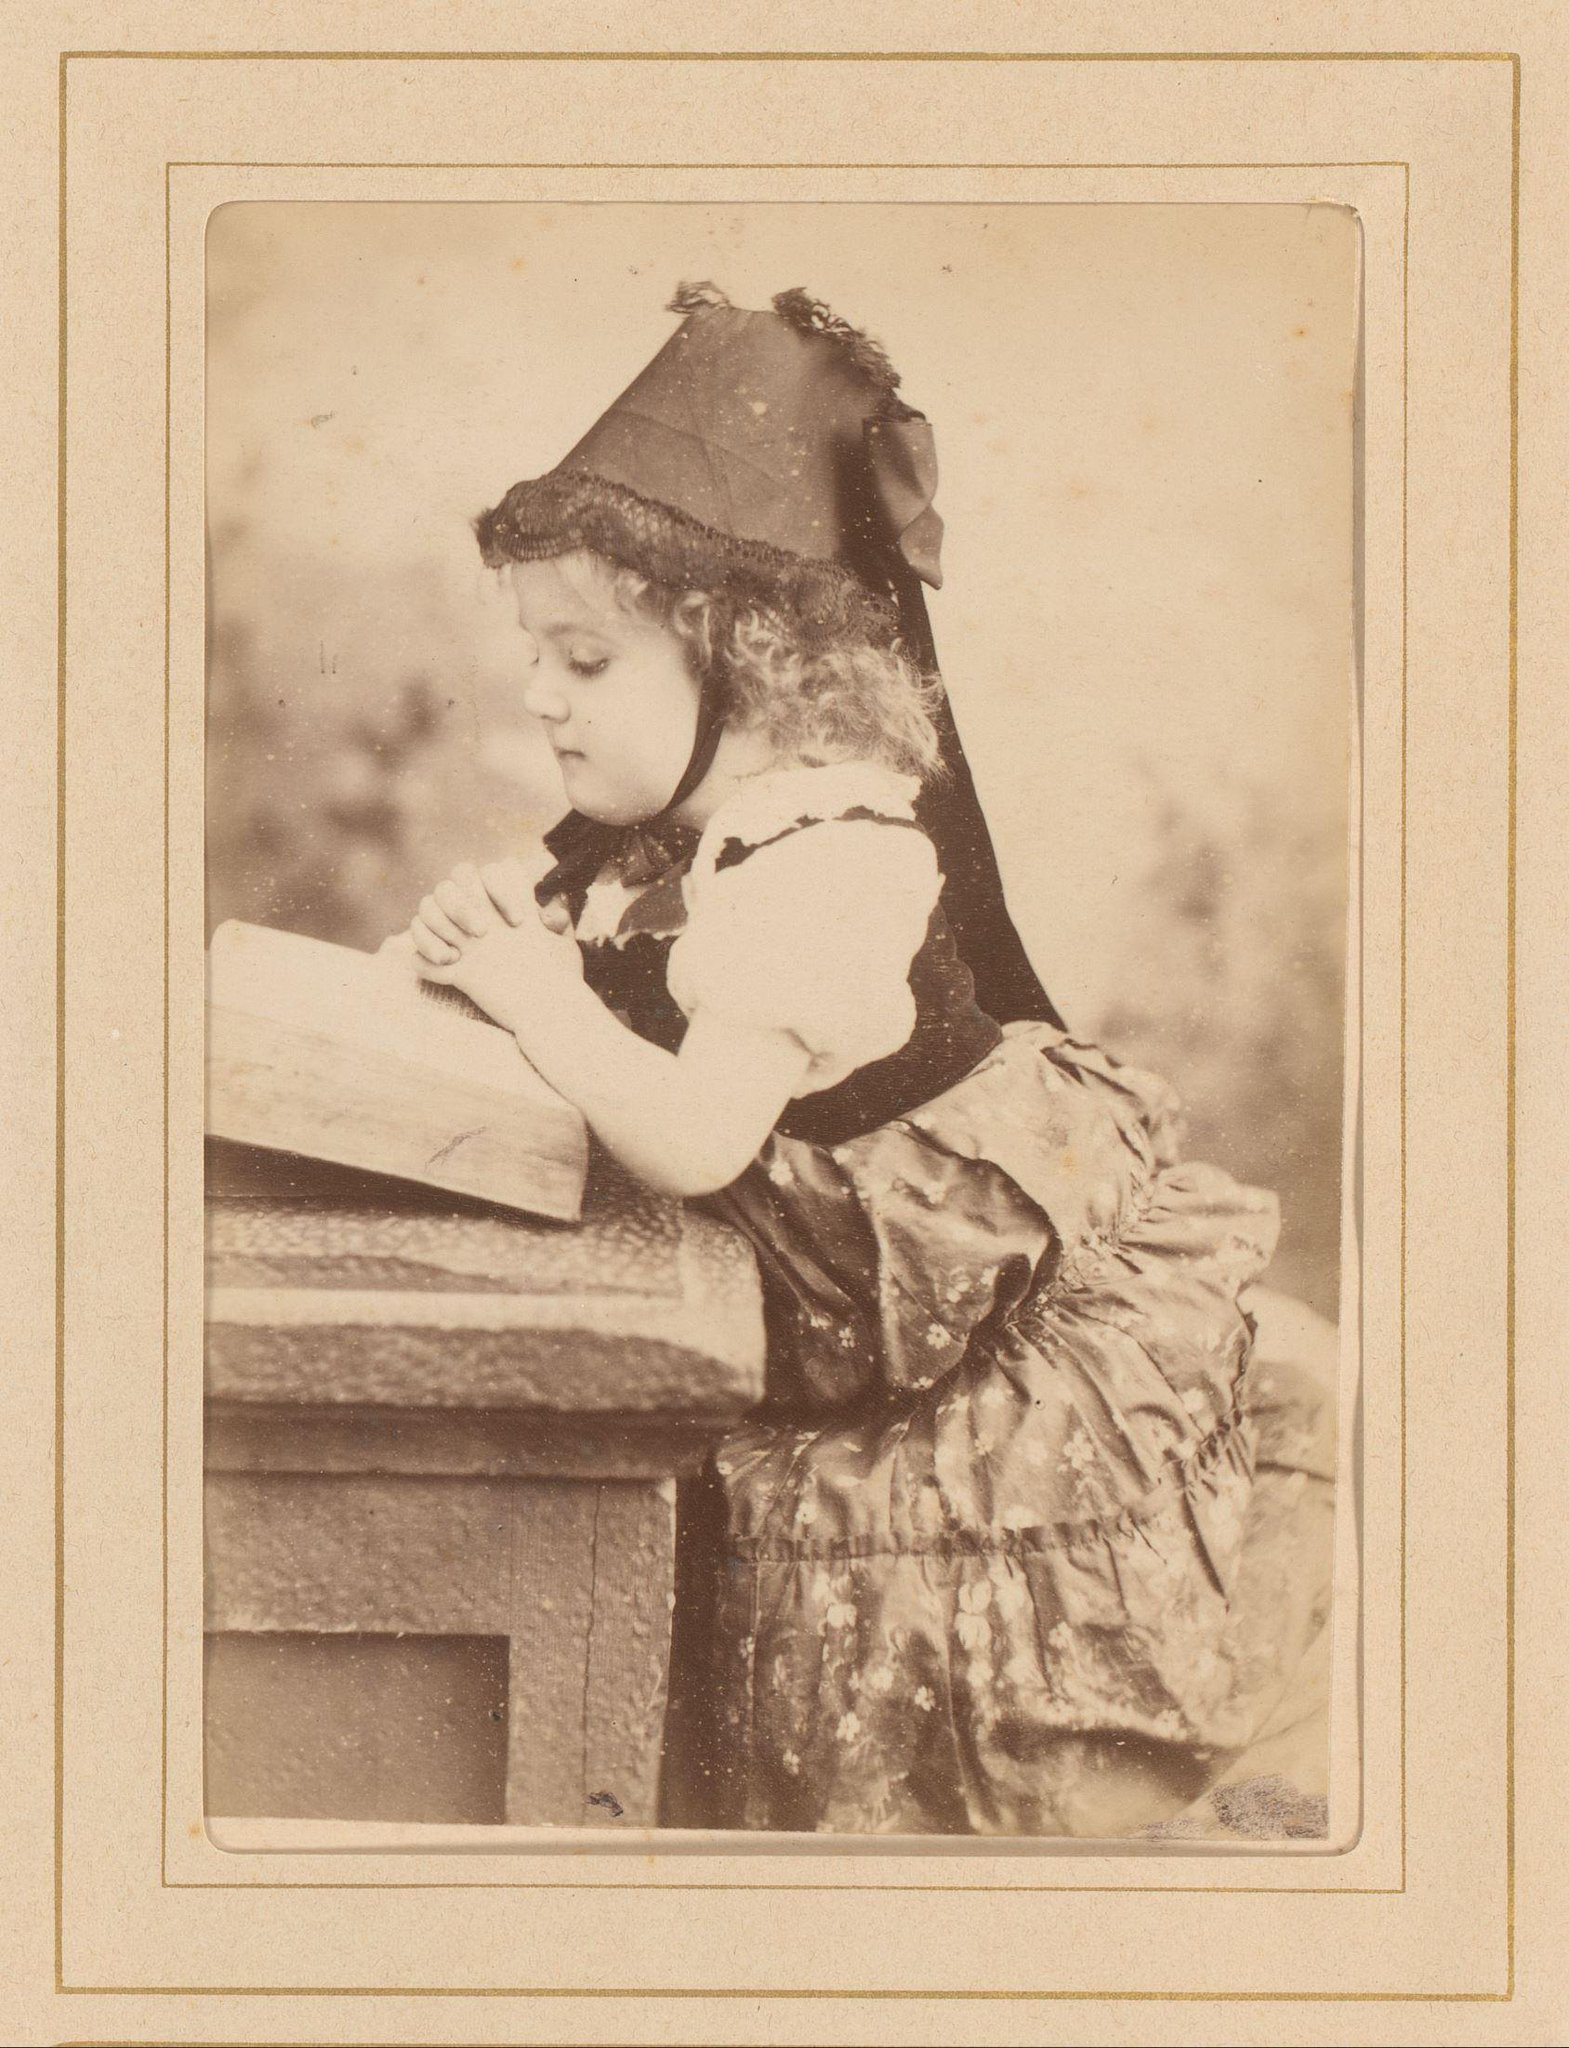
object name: album leaf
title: Portret van een lezend meisje met muts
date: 1884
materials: cardboard, photographic support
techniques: albumen print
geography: berlin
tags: reading, girl (child between toddler and youth), head-gear: cap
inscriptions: inscription: ‘No. 215. Sonntag-Nachmittag. - Dimanche, áprès-midi./ Berlin W. 1884./ E. Linde Kunstverlag’, annotation: ‘De herinnering aan eene afwezigen die [...] lief heeft, is steeds aan genaam/ Oom Theo/ December 84’